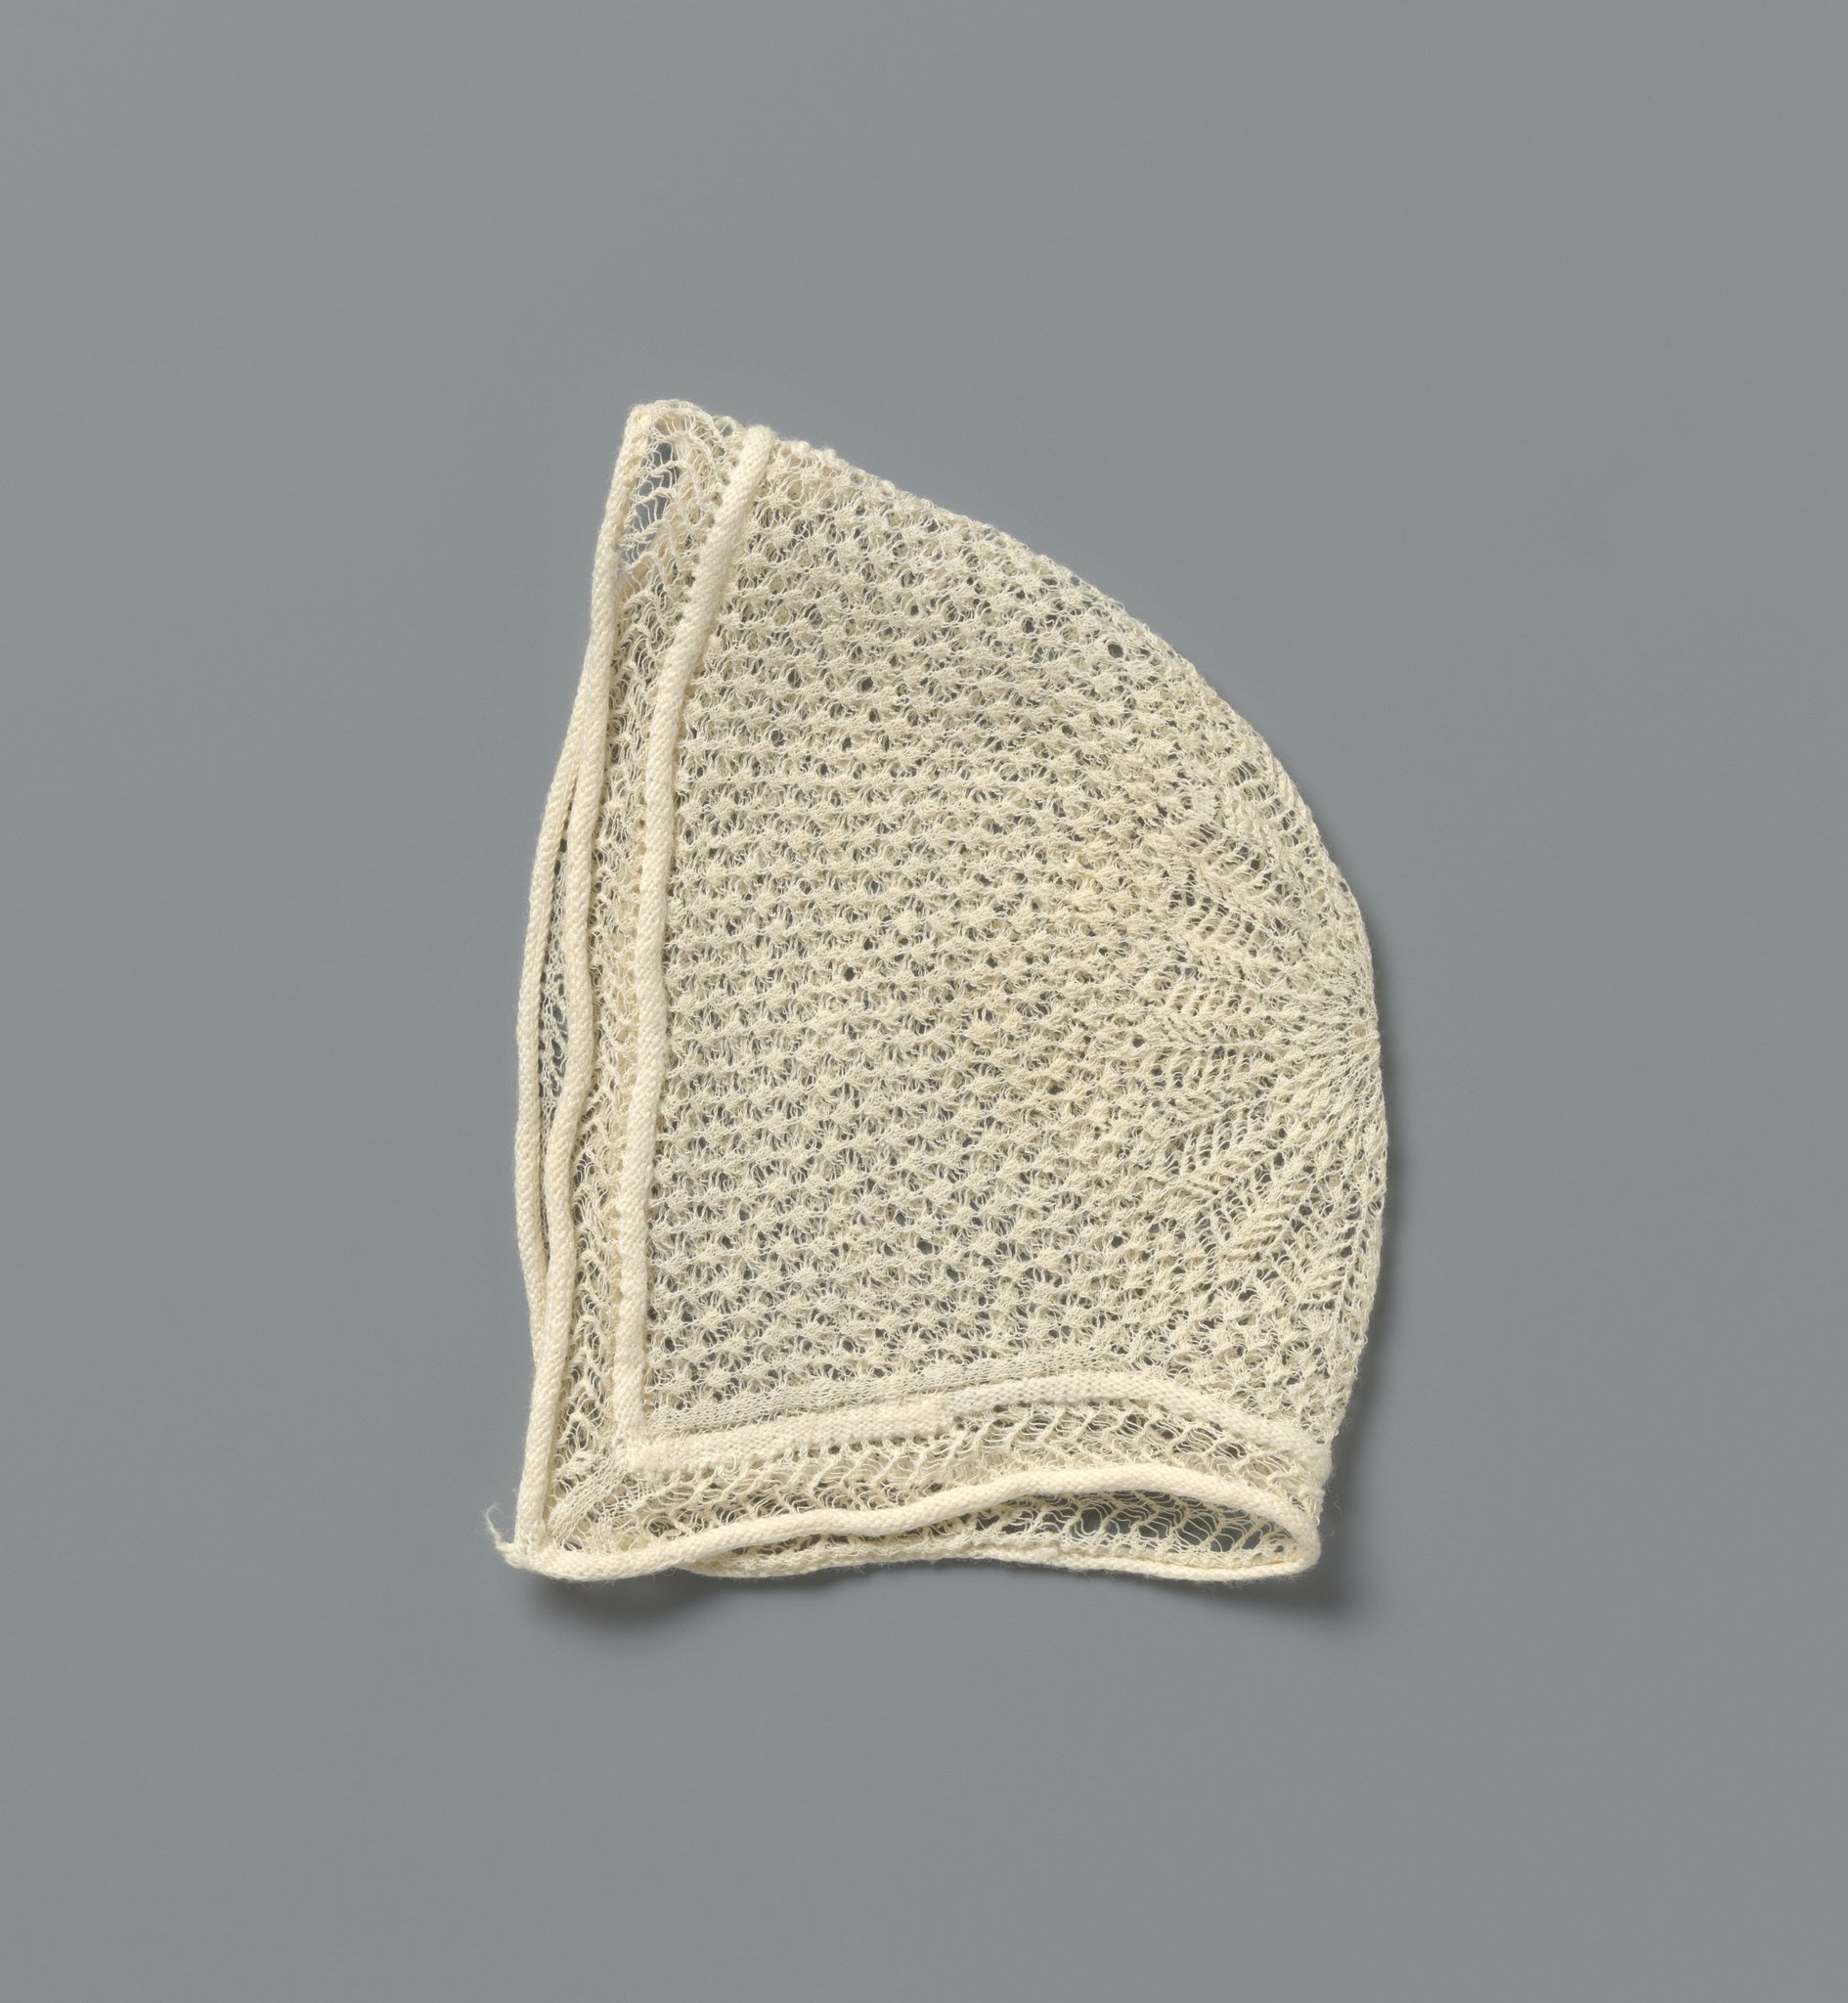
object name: cap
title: Muts van zeer fijne gebreide witte katoen, in de bol stervormig en daarbuiten bezaaid met vlokken; rondom zigzaglijnen tussen twee dikke ribbelranden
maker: Anonymous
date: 1885-1900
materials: cotton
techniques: knitting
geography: netherlands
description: Babymutsje van zeer fijne gebreide katoen. Wit, strak model, met vierkante hoeken over de oren. 't patroon is in de bol stervormig, daarbuiten bezaaid met vlokken. Rand van zigzaglijnen tussen twee dikke ribbelrandjes.